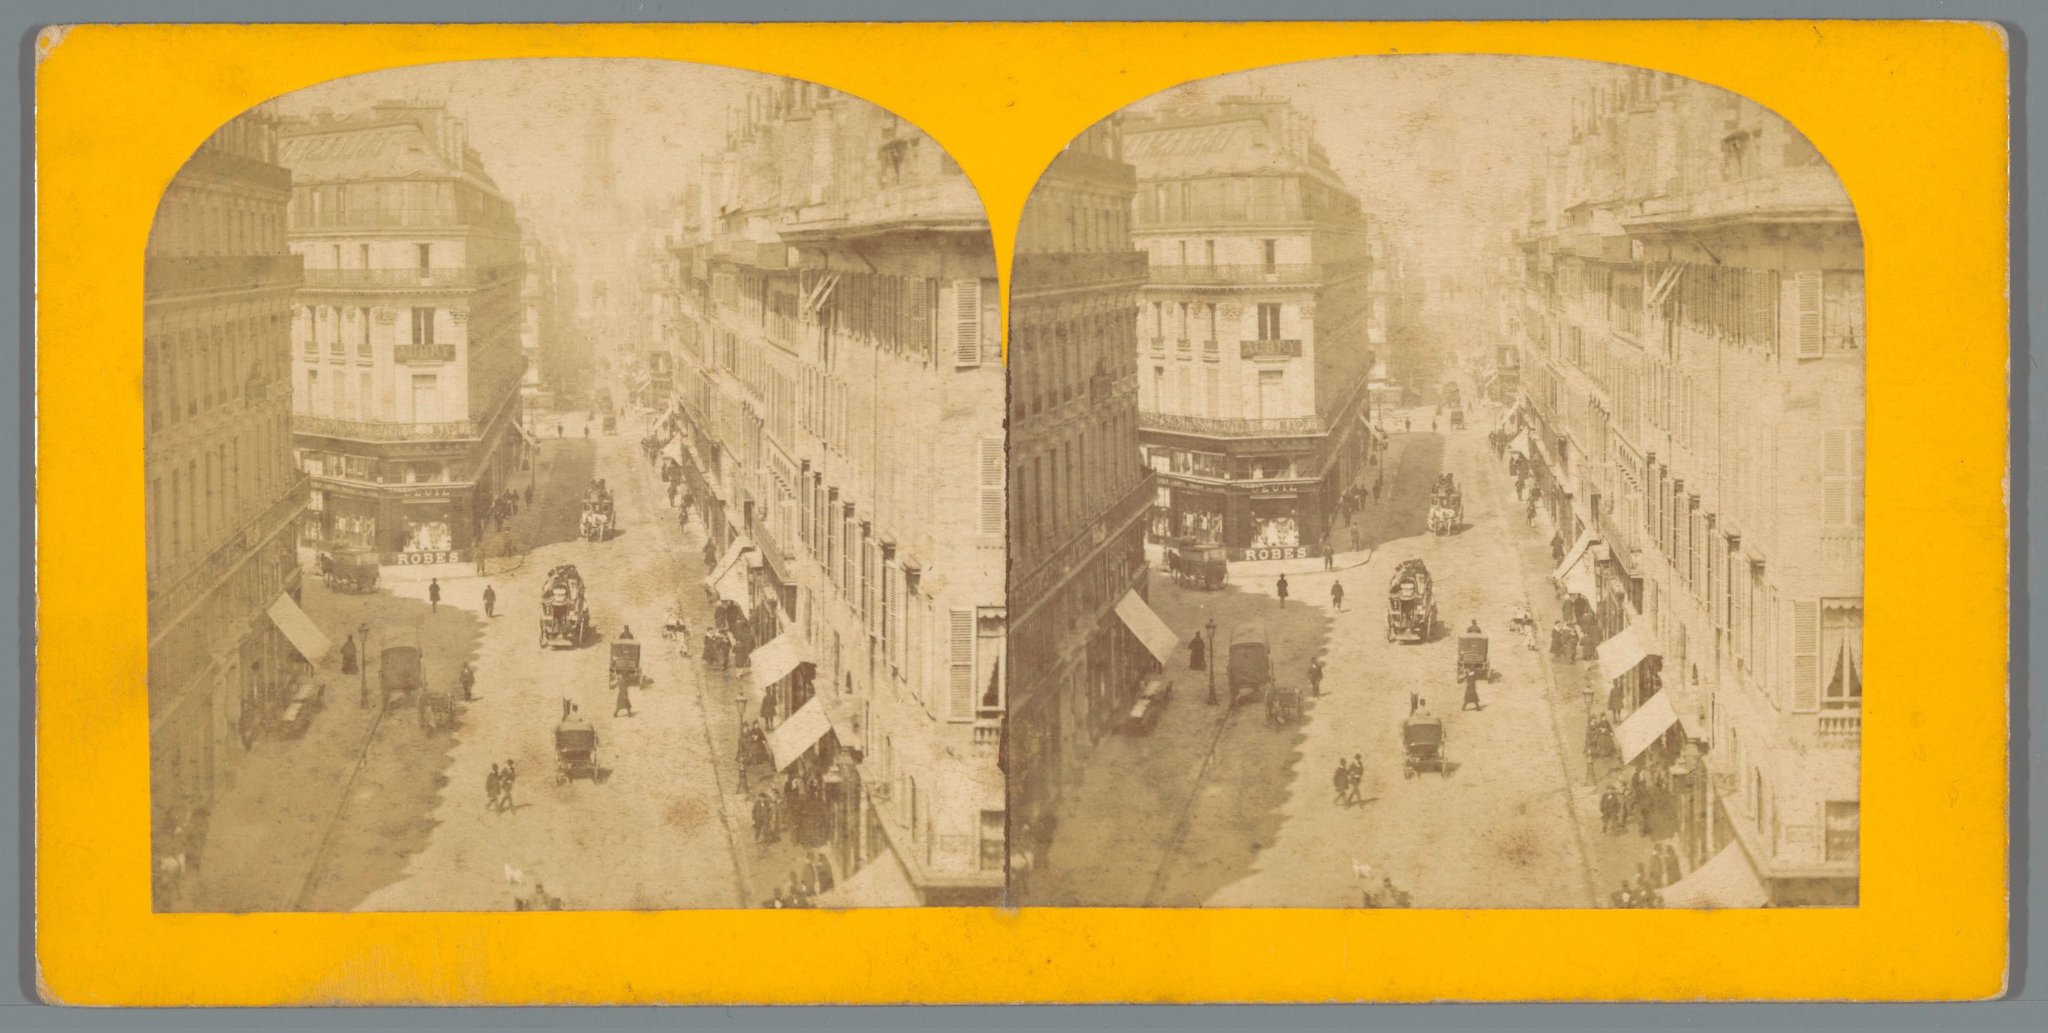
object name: stereograph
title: Gezicht op de Rue de la Chaussée-d'Antin in Parijs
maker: Anonymous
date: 1850-1880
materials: cardboard, photographic support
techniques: albumen print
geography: paris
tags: animal traction, animal-drawn vehicle (carriage etc.), street, paris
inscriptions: inscription: ‘Rue de la Chausseé d'Antin’